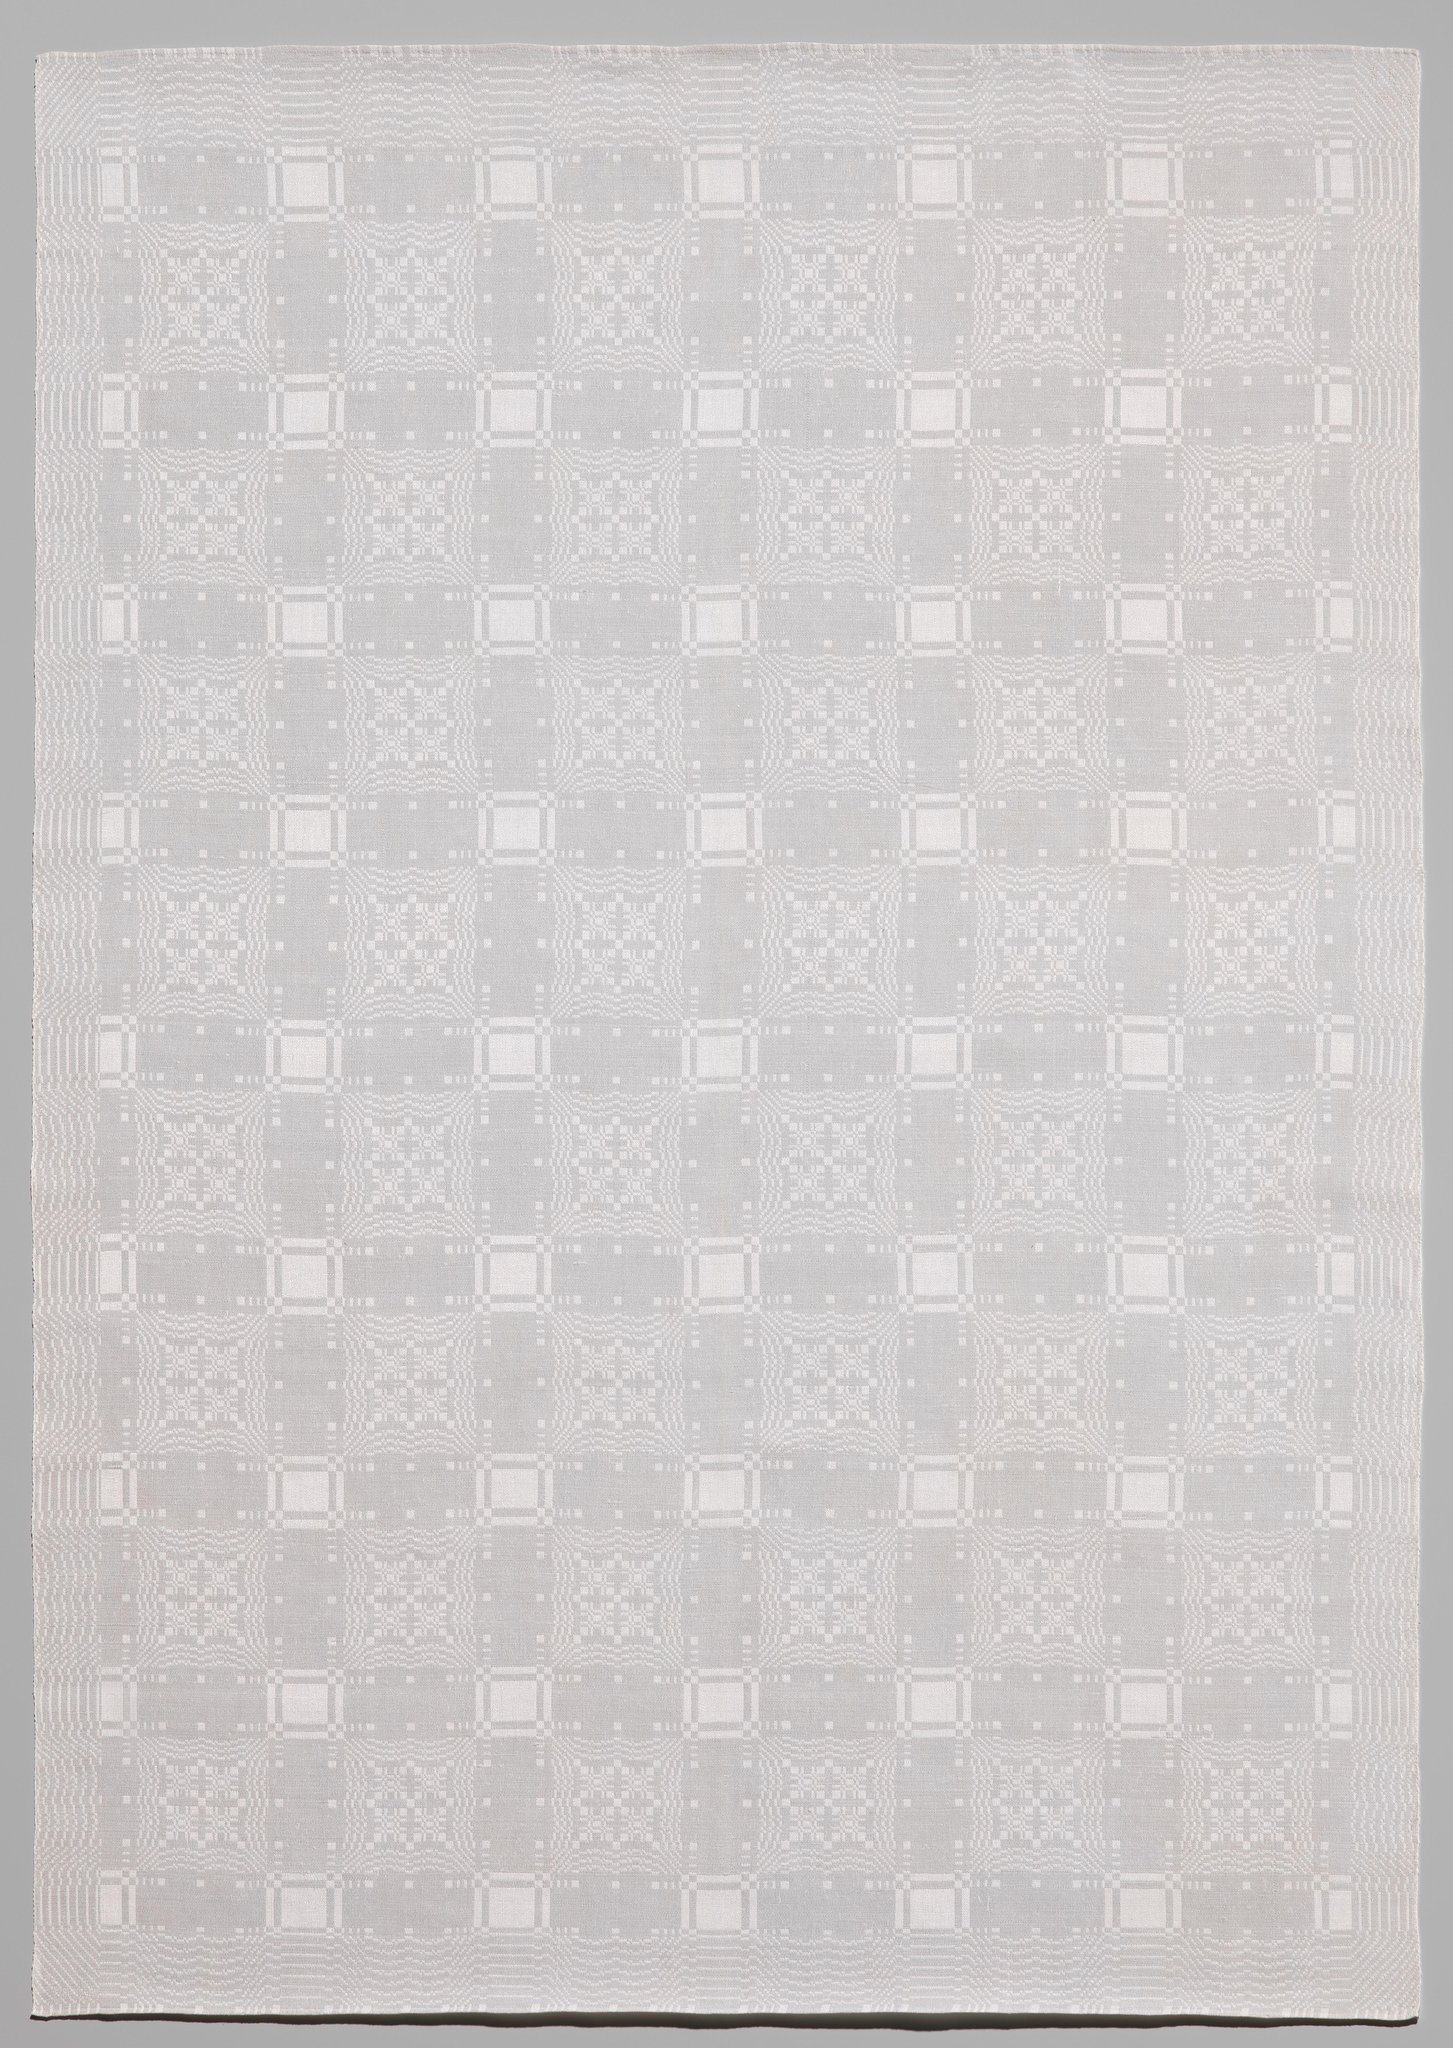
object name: napkin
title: Servet van linnen met pellenpatroon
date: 1734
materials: linen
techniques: peeled fabric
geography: northern netherlands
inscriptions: : ‘AVG 38’, : ‘1734’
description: wit linnen servet met pellen patroon, merk AVG 38 en 1734